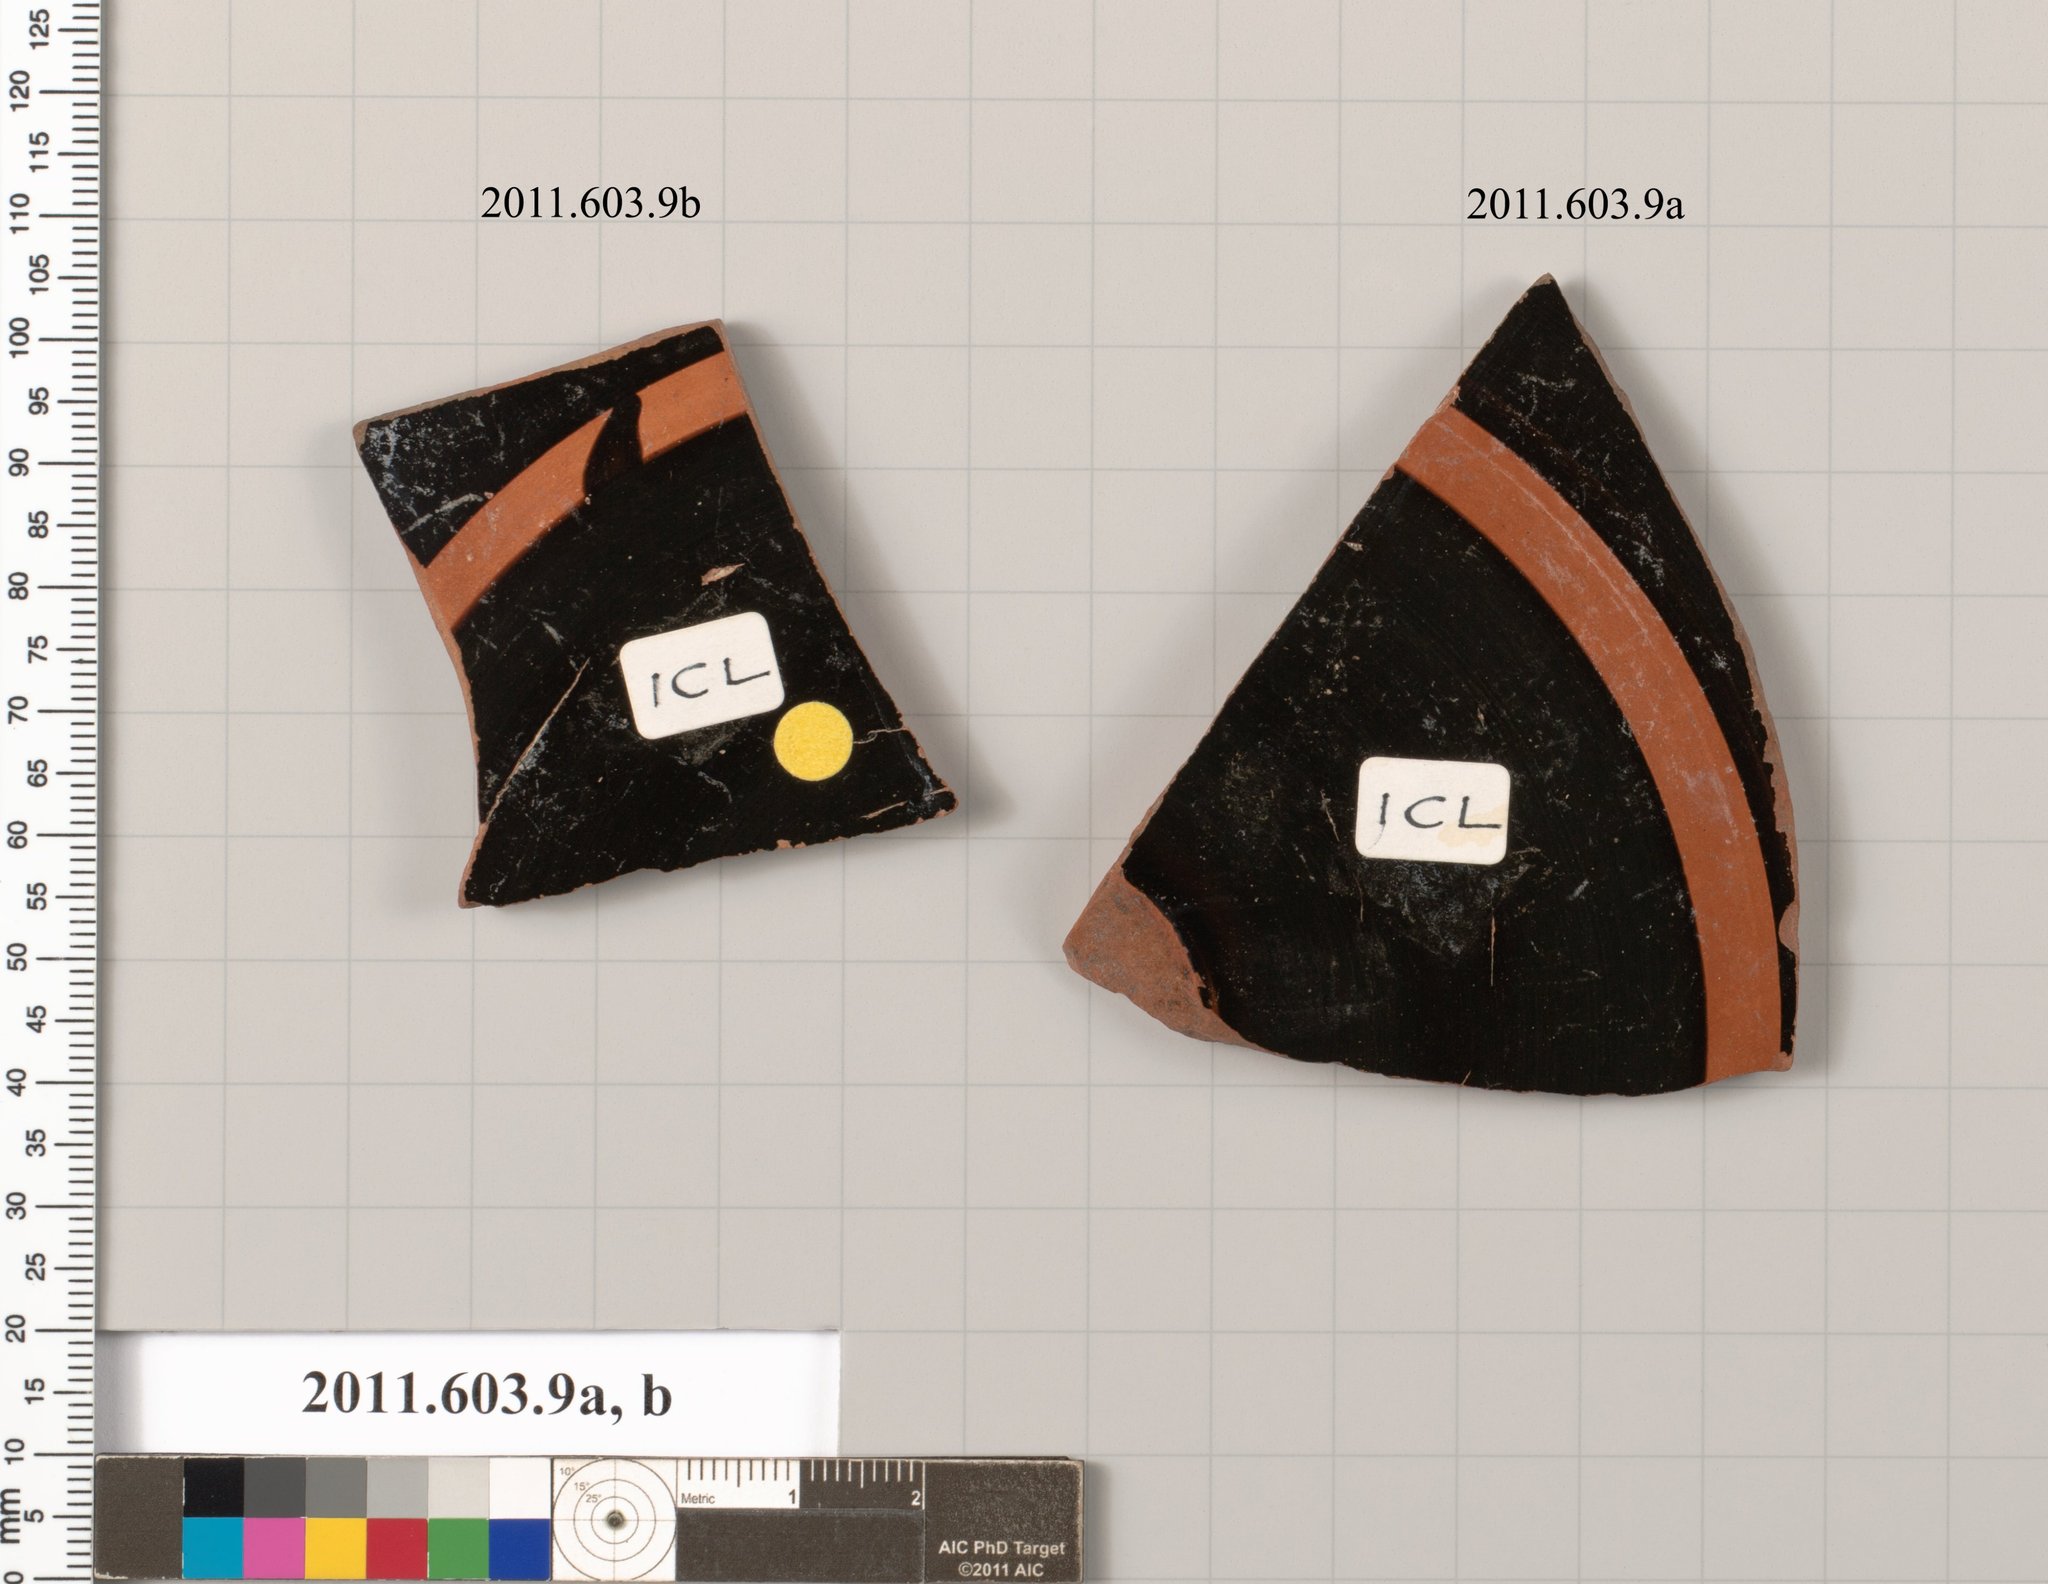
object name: kylix fragment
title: Fragments of a terracotta kylix:band-cup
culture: greek, attic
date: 550-526 BCE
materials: terracotta